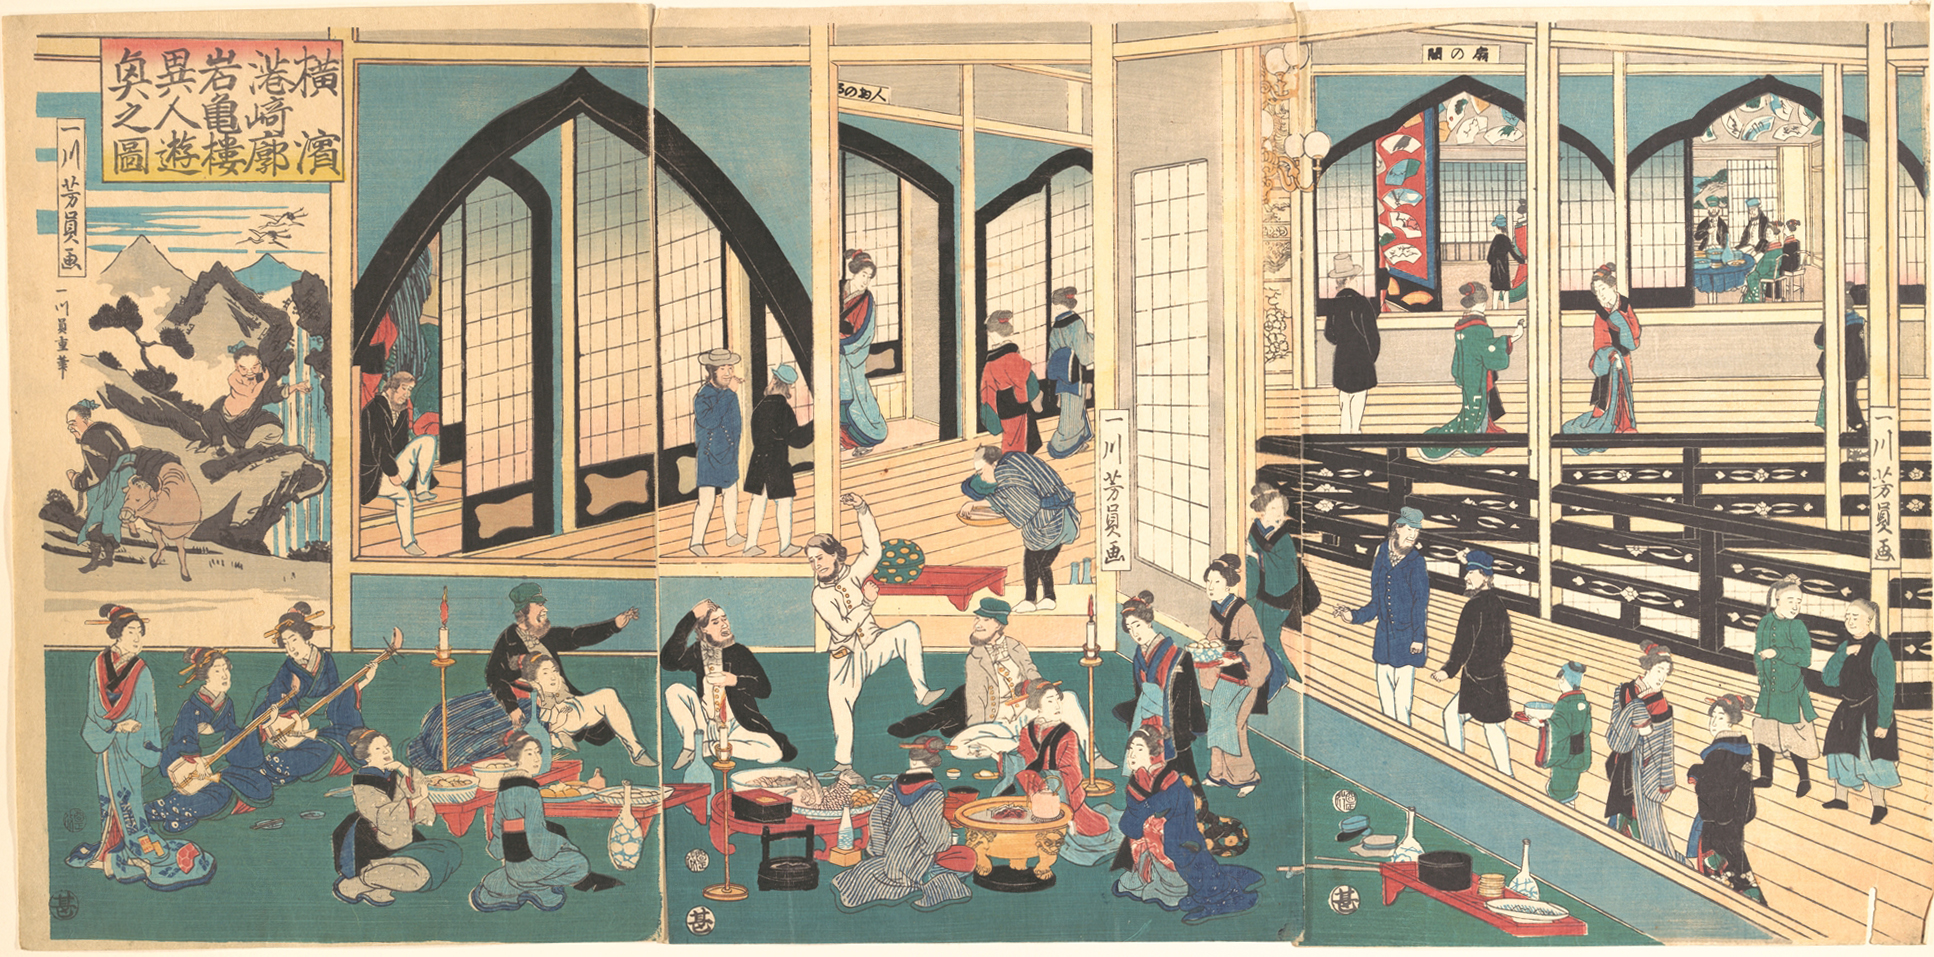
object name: print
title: Foreigners Enjoying a Party at the Gankirō Tea House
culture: japanese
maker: utagawa yoshikazu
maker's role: artist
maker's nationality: japanese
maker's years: 1845-1870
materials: ink, paper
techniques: woodblock print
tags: men,women,party,musicians,eating,tea houses